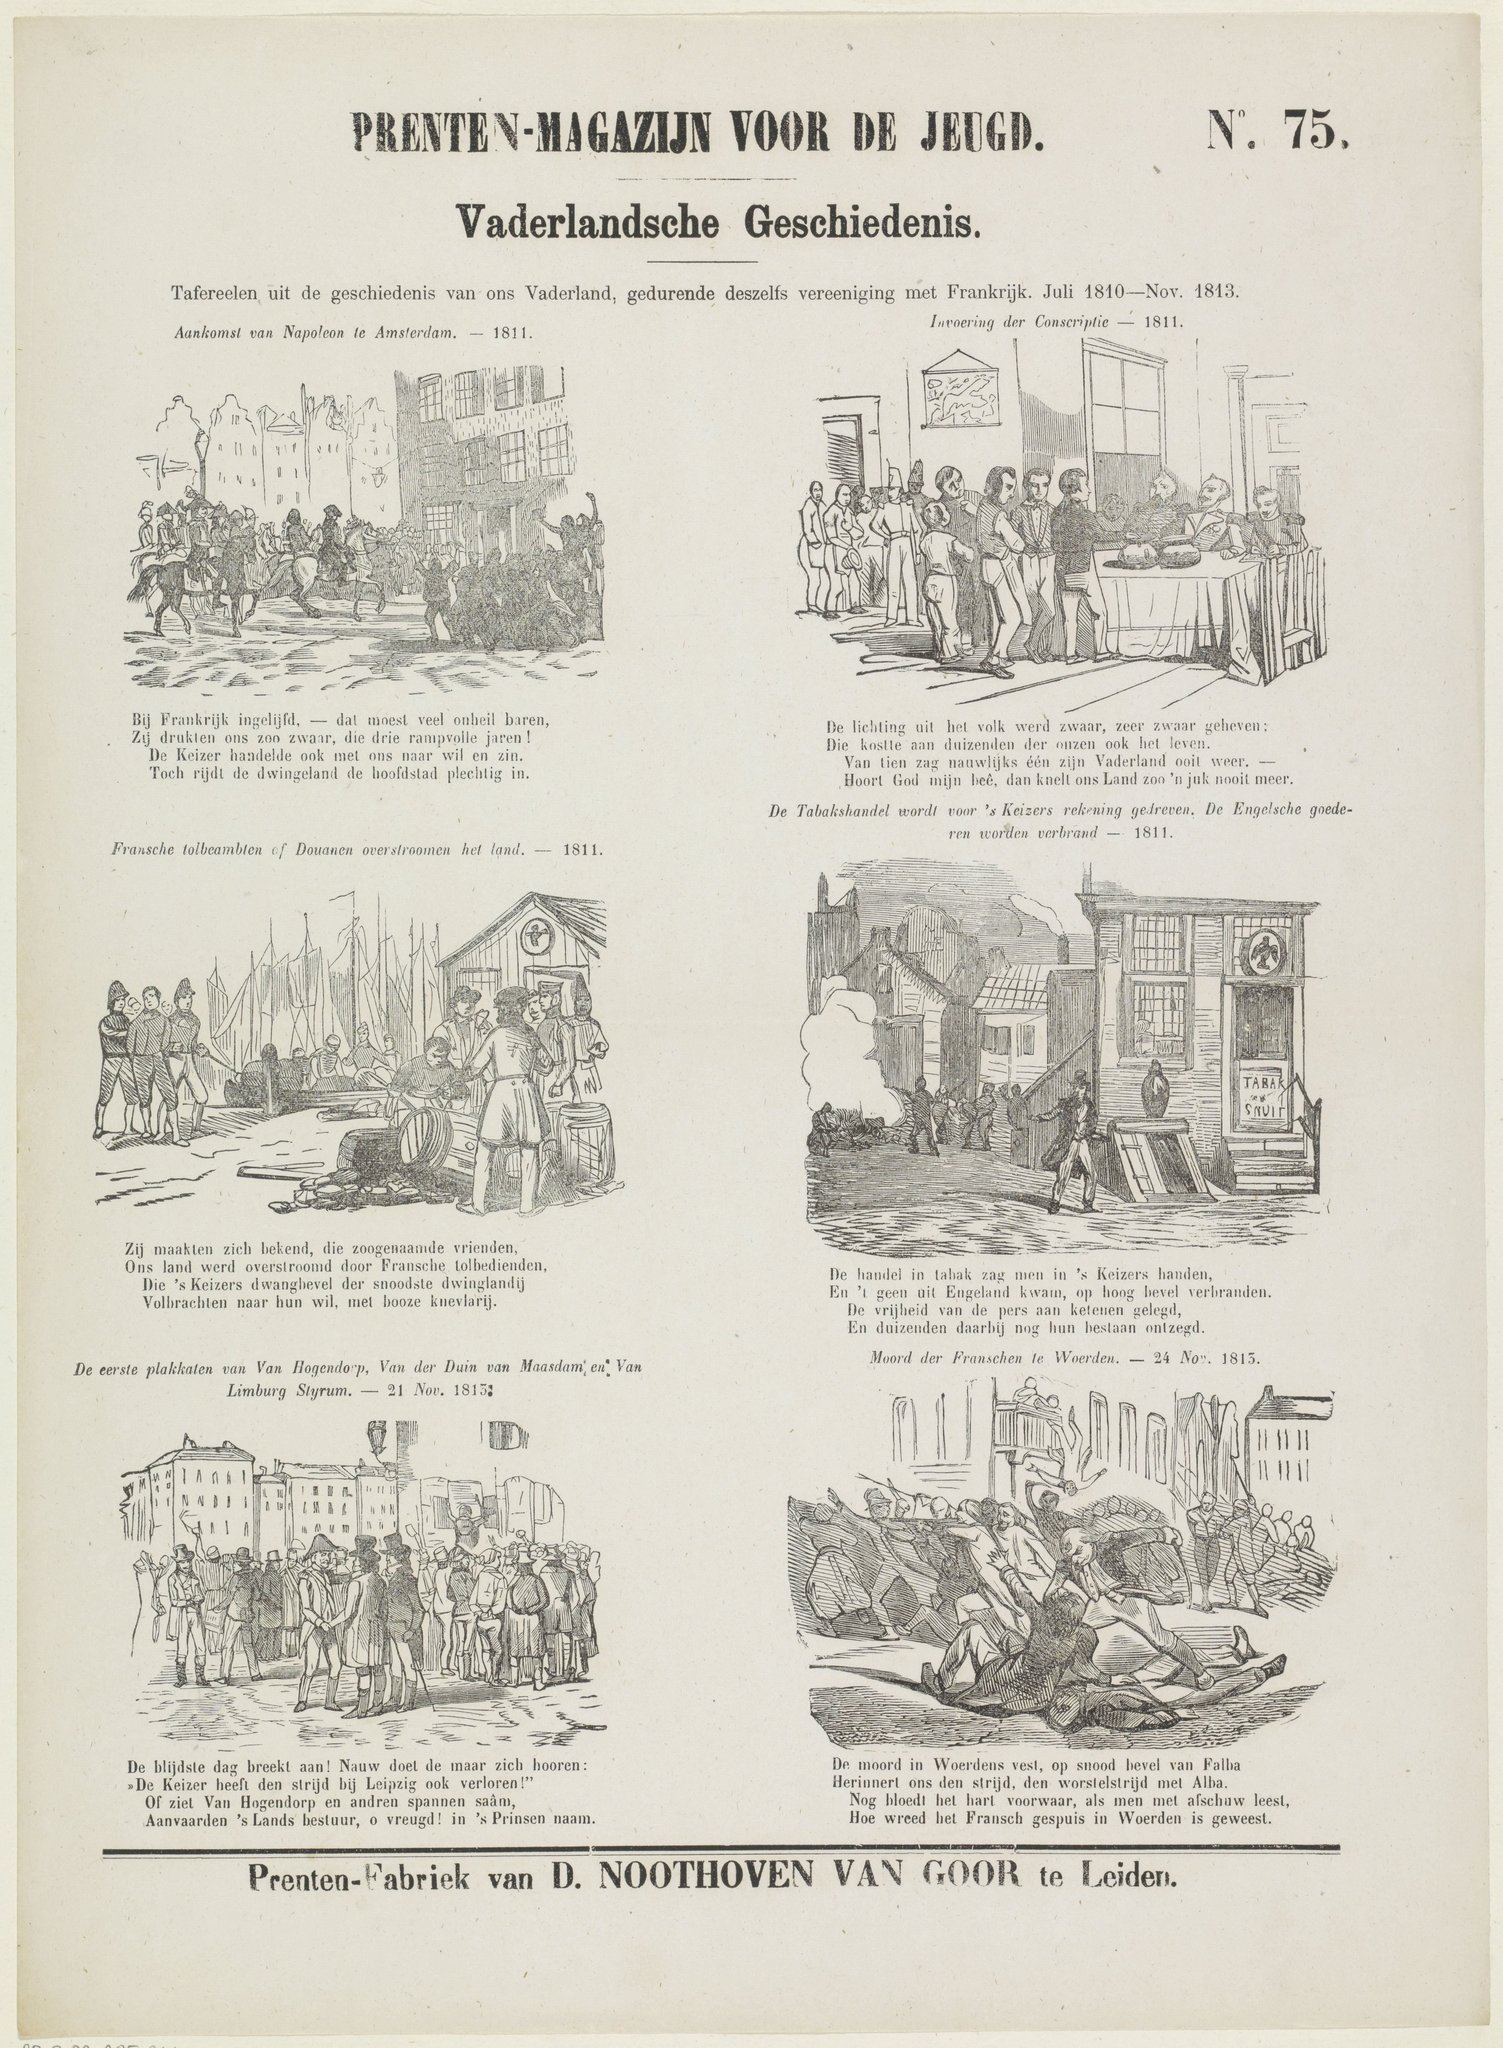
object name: print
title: Prenten-magazijn voor de jeugd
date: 1850-1881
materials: paper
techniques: letterpress printing, engraving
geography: netherlands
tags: napoleon i (emperor of the french), history, netherlands, amsterdam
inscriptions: collector's mark: Lugt 2760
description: Blad met 6 voorstellingen van gebeurtenissen ten tijde van de Franse Tijd (1810-1813). Boven elke voorstelling een titel en onder elke voorstelling een vierregelig vers. Genummerd rechtsboven: No. 75.